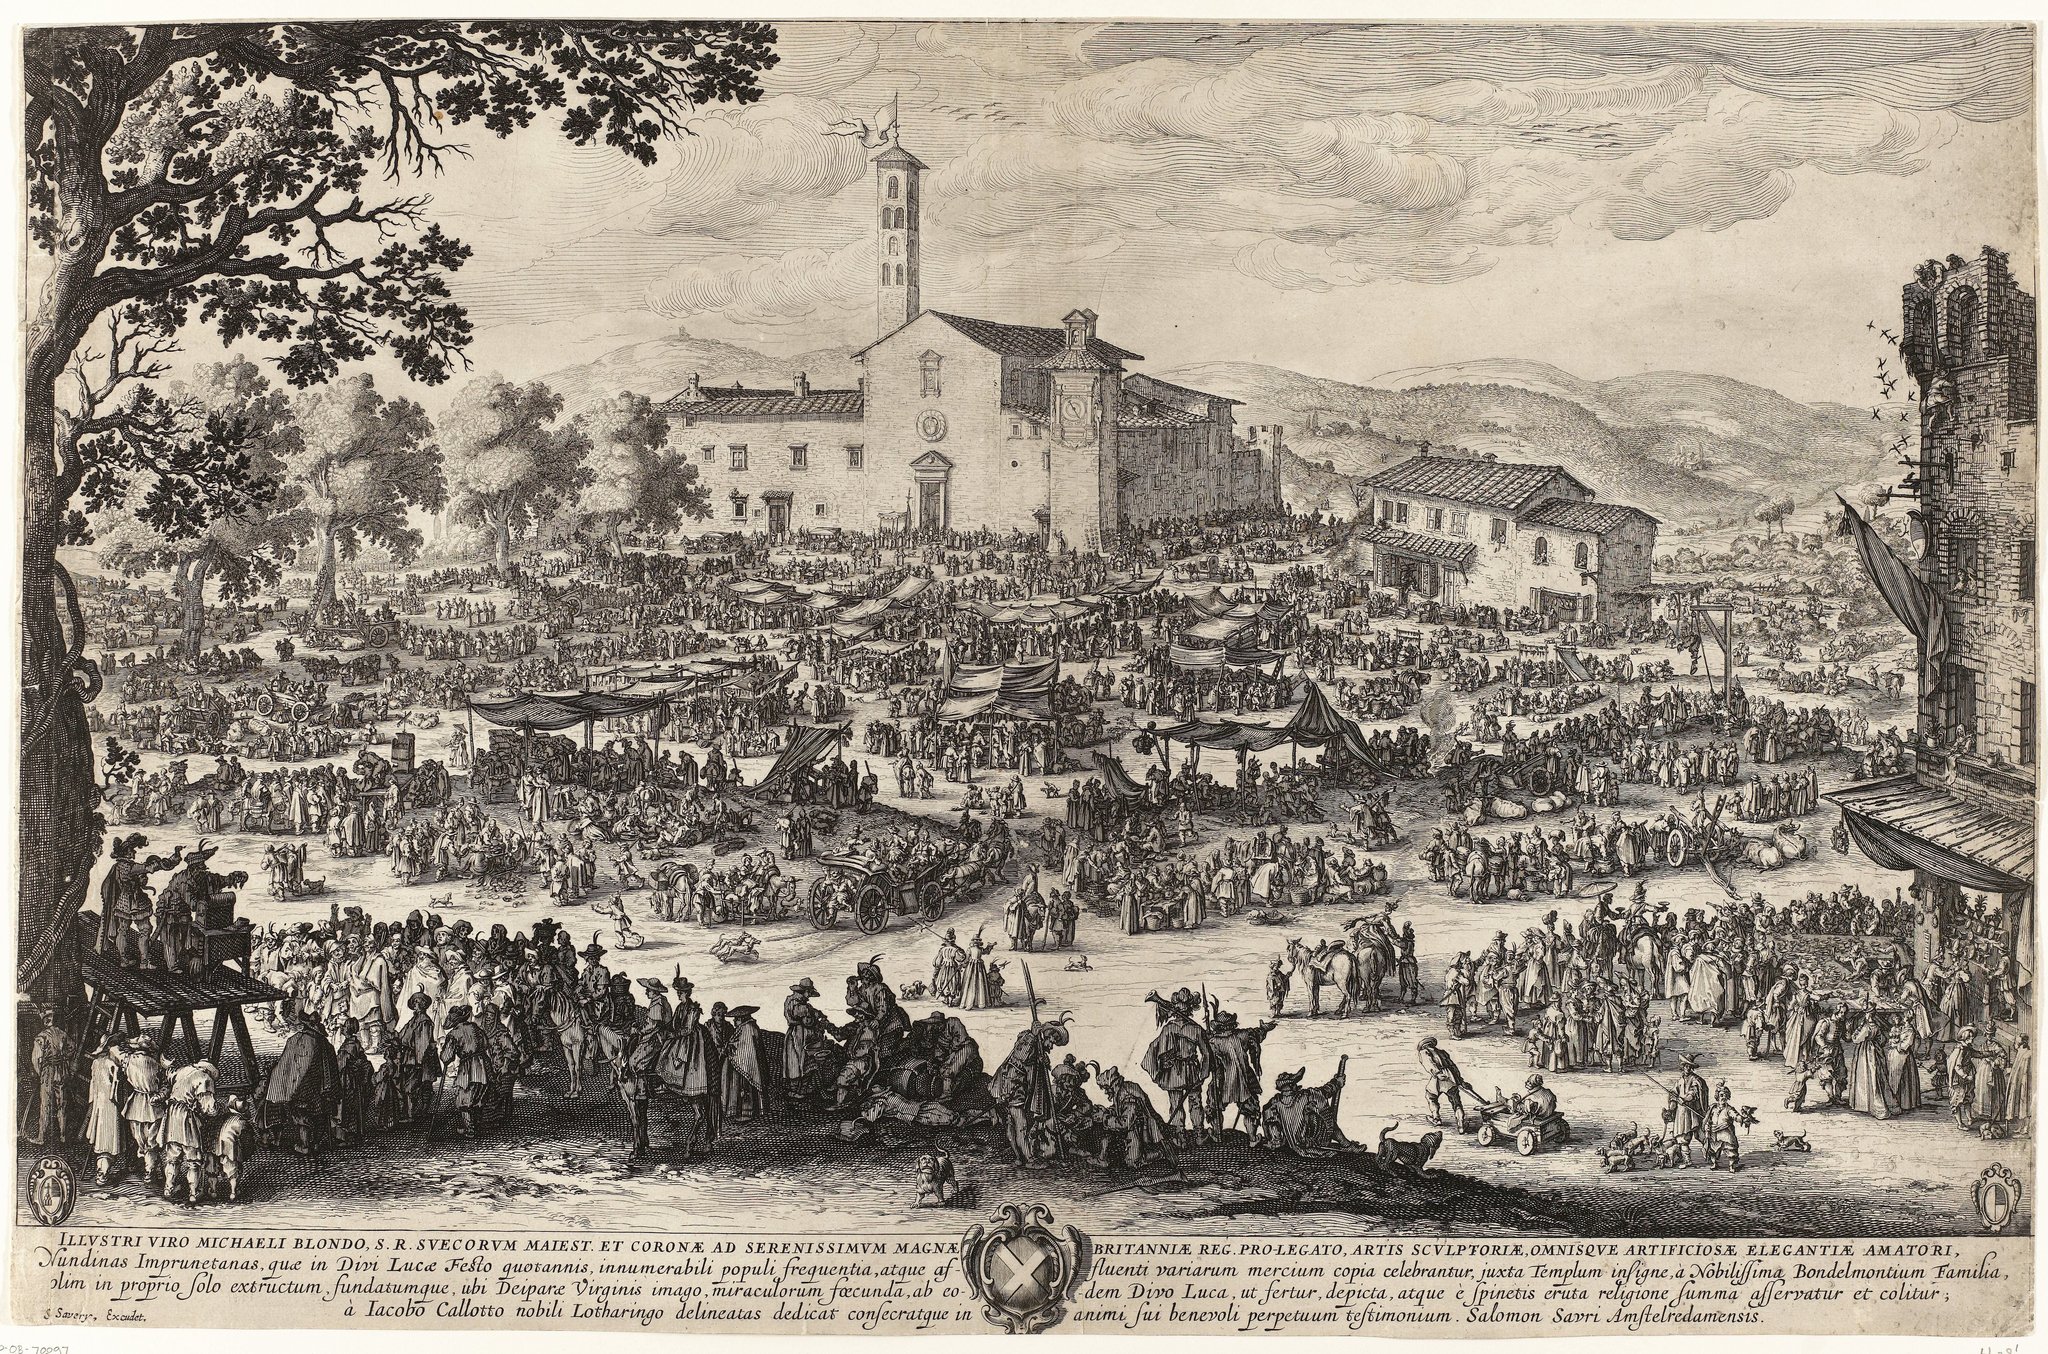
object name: print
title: Jaarmarkt te Impruneta nabij Florence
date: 1620-1683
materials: paper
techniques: engraving, etching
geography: amsterdam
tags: (annual) fair, trade fair, village square, place, armorial bearing, heraldry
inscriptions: collector's mark: Lugt 2228, collector's mark: Lugt 240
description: Jaarmarkt op 18 oktober te Impruneta, een dorp nabij Florence: een grote menigte kraampjes, handelaren en bezoekers op een plein voor een kerk. Rechtsonder het wapen van de Santa Mariakerk te Impruneta, linksonder het wapen van de familie Buondelmonti (die de kerk stichtte), middenonder het wapen van Michael Blondo. Onder de voorstelling een vierregelig onderschrift met een opdracht in het Latijn.